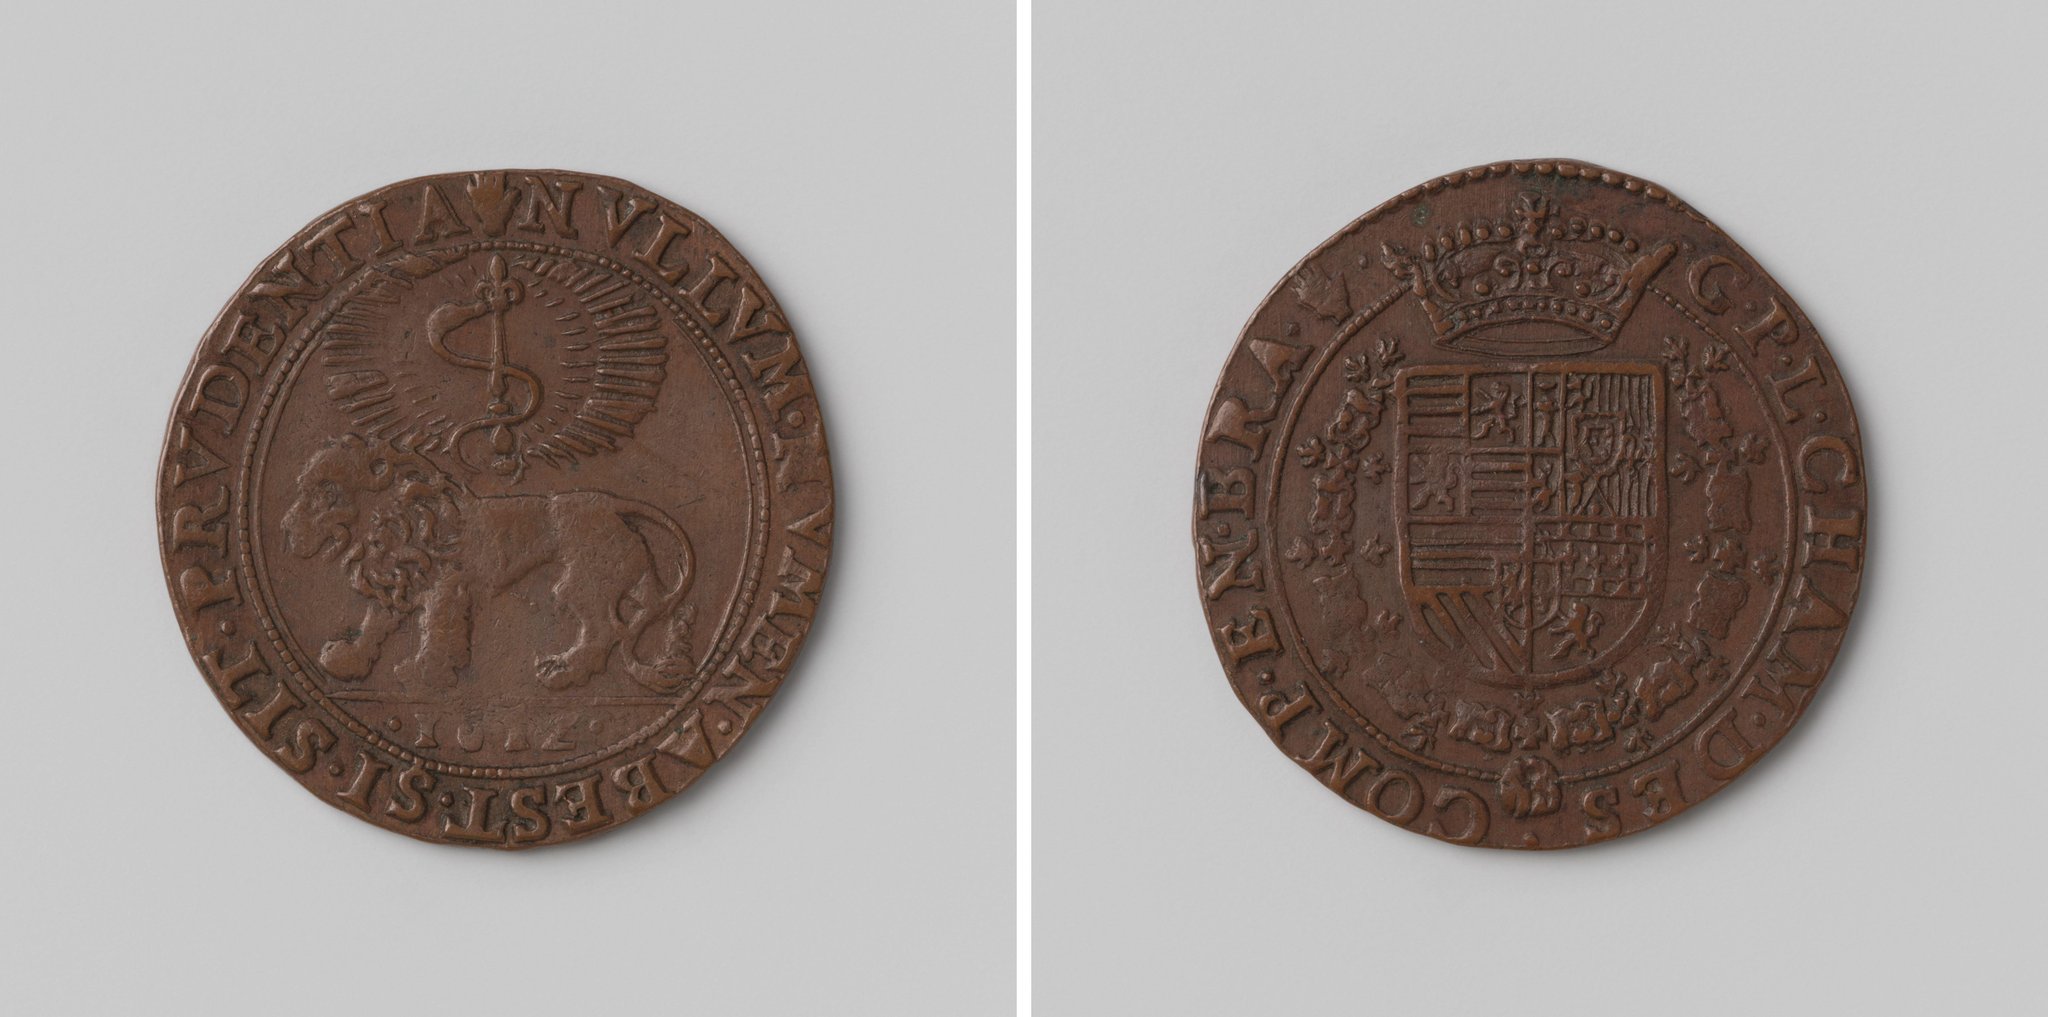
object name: jeton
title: Aken in de rijksban gedaan, rekenpenning geslagen op last van de rekenkamer van Brabant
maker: Anonymous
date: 1612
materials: copper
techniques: striking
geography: antwerp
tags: infante van spanje isabella clara eugenia, brussels, albrecht aartshertog van oostenrijk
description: Koperen penning. Voorzijde: scepter, waarom zich slang heeft gekronkeld binnen stralenkrans boven leeuw binnen omschrift; afsnede: jaartal. Keerzijde: gekroond wapenschild, omhangen met de orde van het Gulden Vlies binnen omschrift